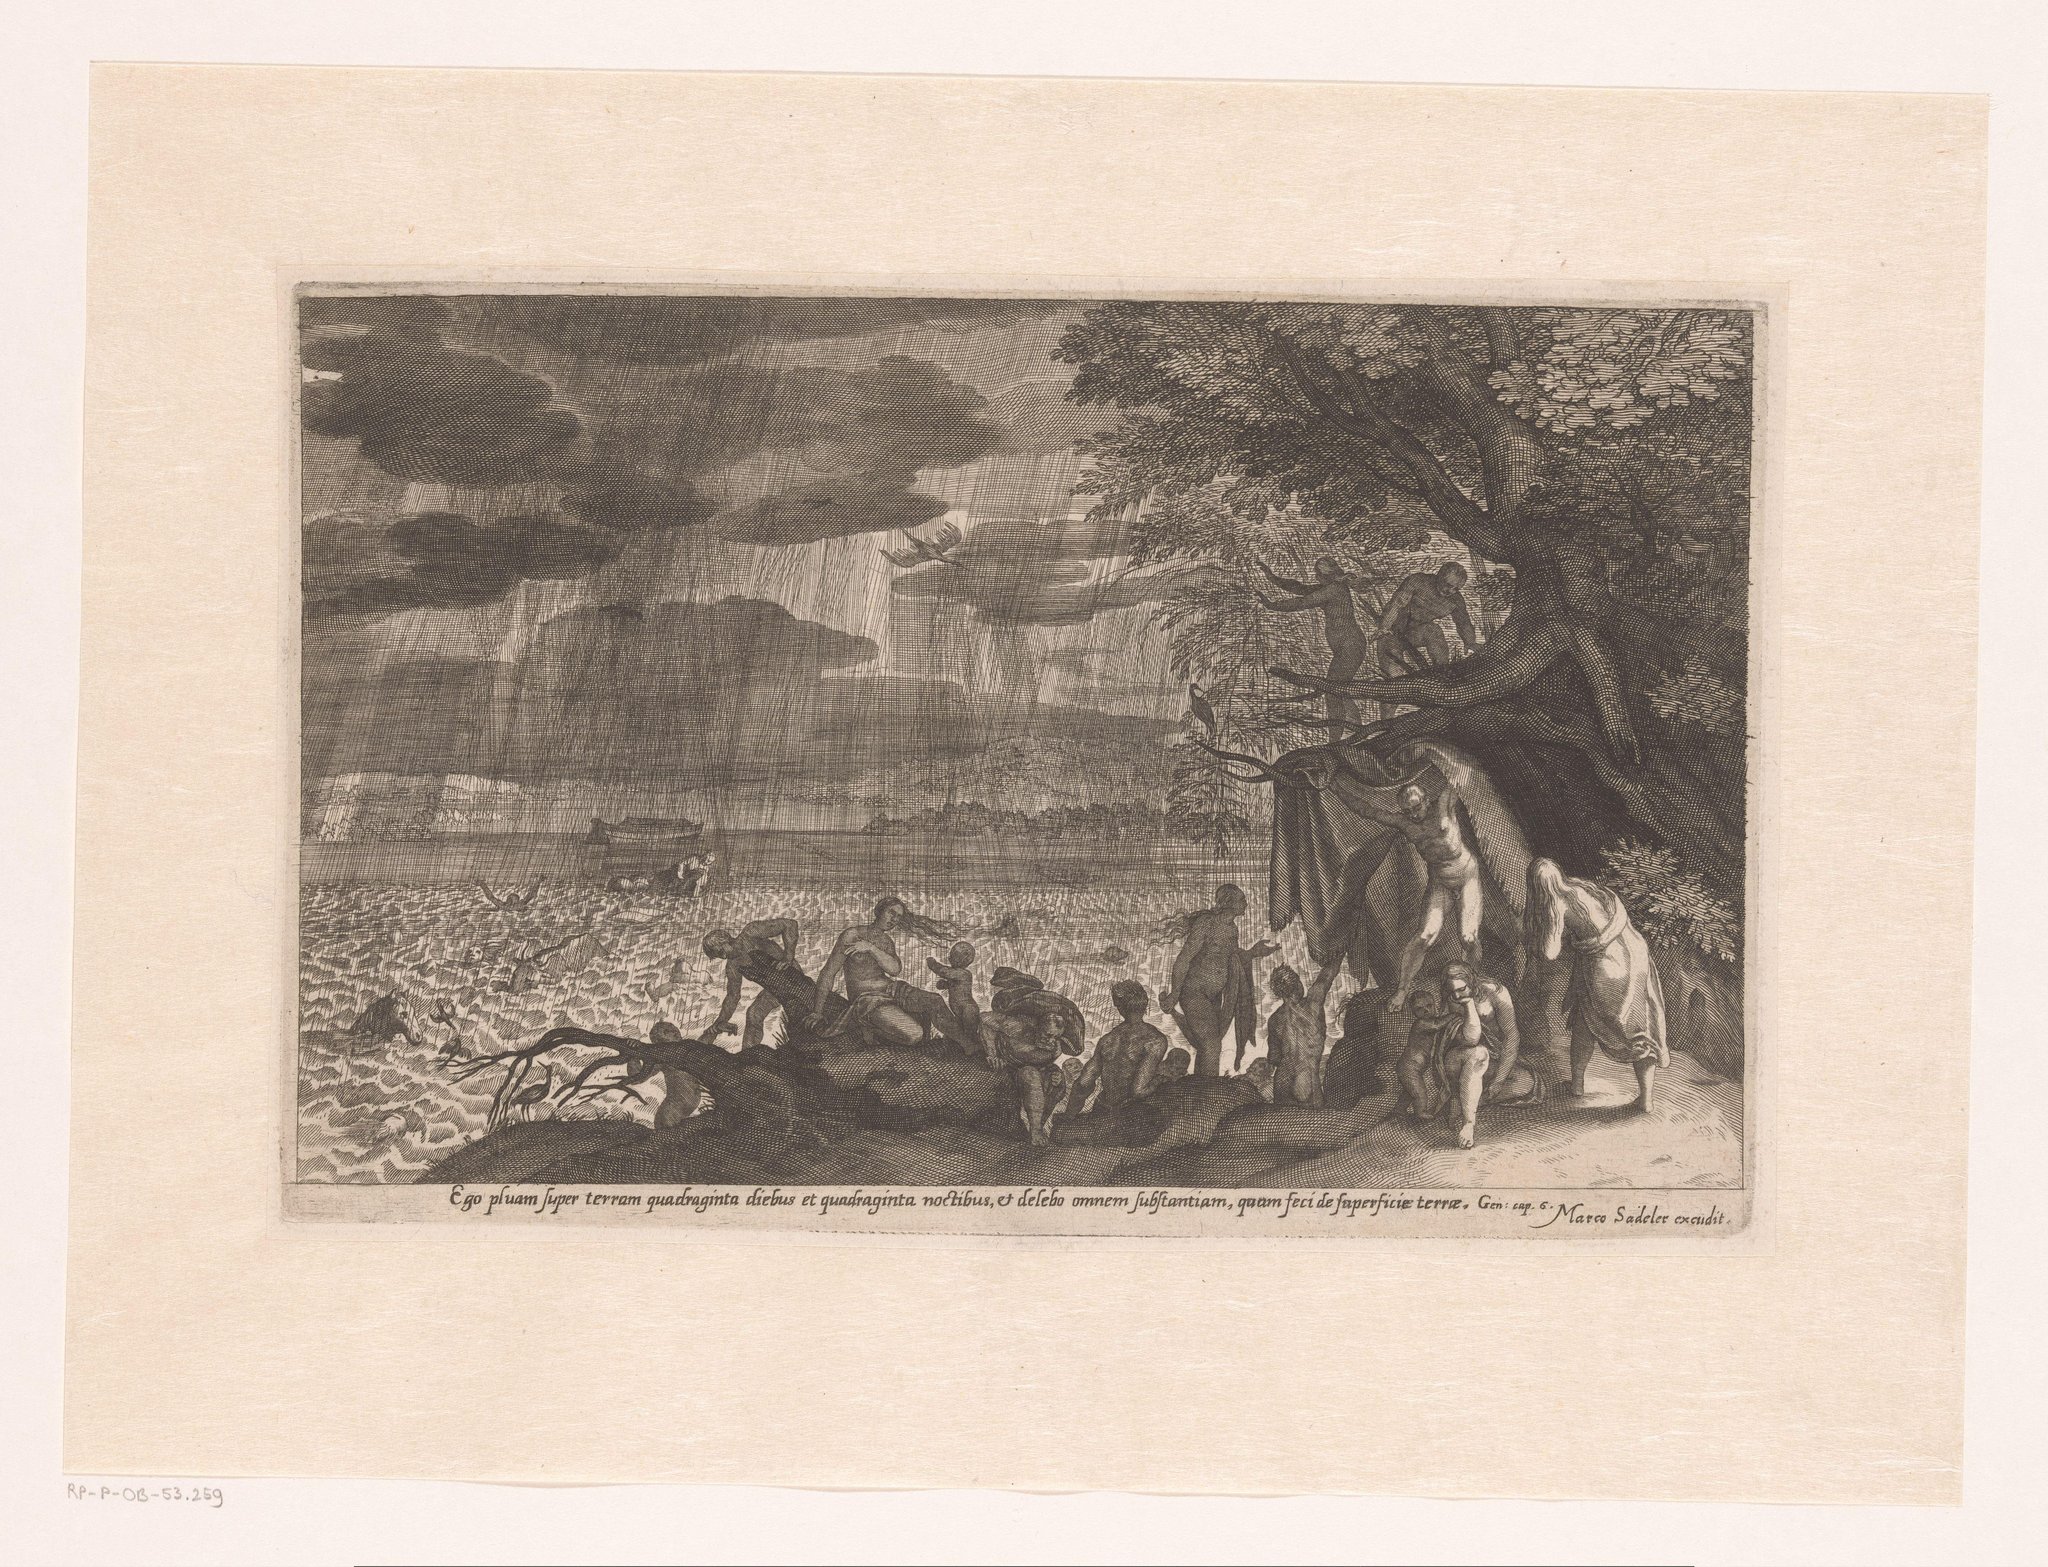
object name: print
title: Zondvloed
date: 1586-1630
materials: paper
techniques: engraving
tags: the flood and destruction of mankind ~ story of noah (genesis 7:10 - 8:17)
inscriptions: collector's mark: Lugt 240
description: De zondvloed overstroomt het land. Mensen en dieren worden verzwolgen door het water. Mensen proberen te ontsnappen aan het stijgende water. Onder de voorstelling een regel tekst in het Latijn.